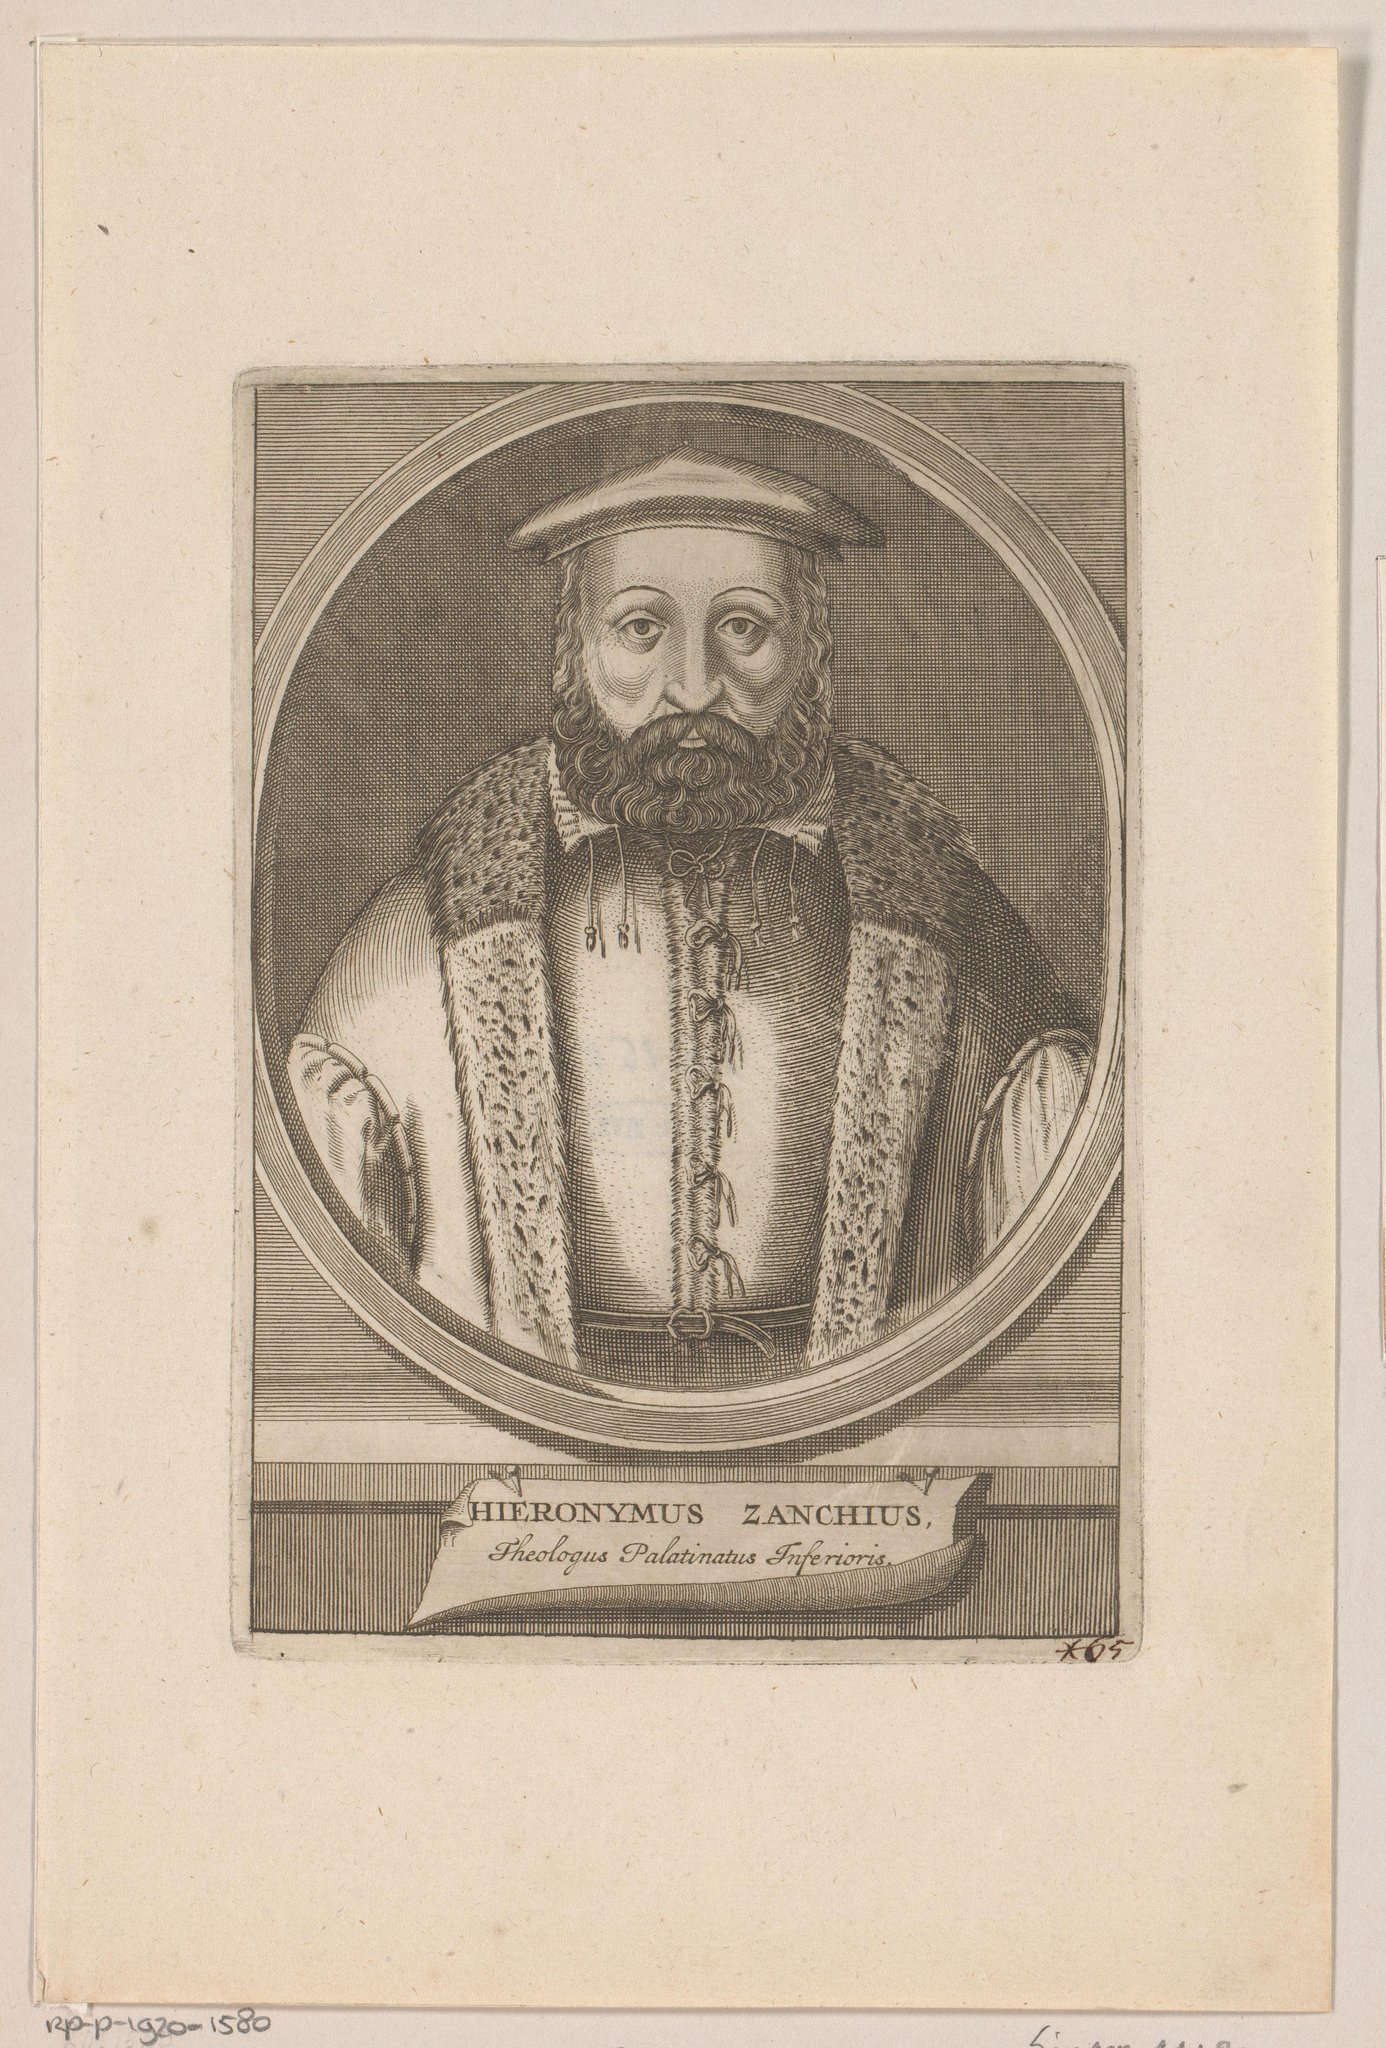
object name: print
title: Portret van Hieronymus Zanchius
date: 1690-1729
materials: paper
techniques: engraving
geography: the hague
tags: reformation (roman catholic church vs. protestantism), theologian, historical persons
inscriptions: number: ‘*65’, collector's mark: Lugt 2228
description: Prent waarschijnlijk uit een editie van: Le miroir des portraits des premiers reformateurs des eglises protestantes. Leiden: Pieter van der Aa, [1690-1729]. Eerdere staat gebruikt in serie uit 1599 en publicaties uit 1602 en 1603.